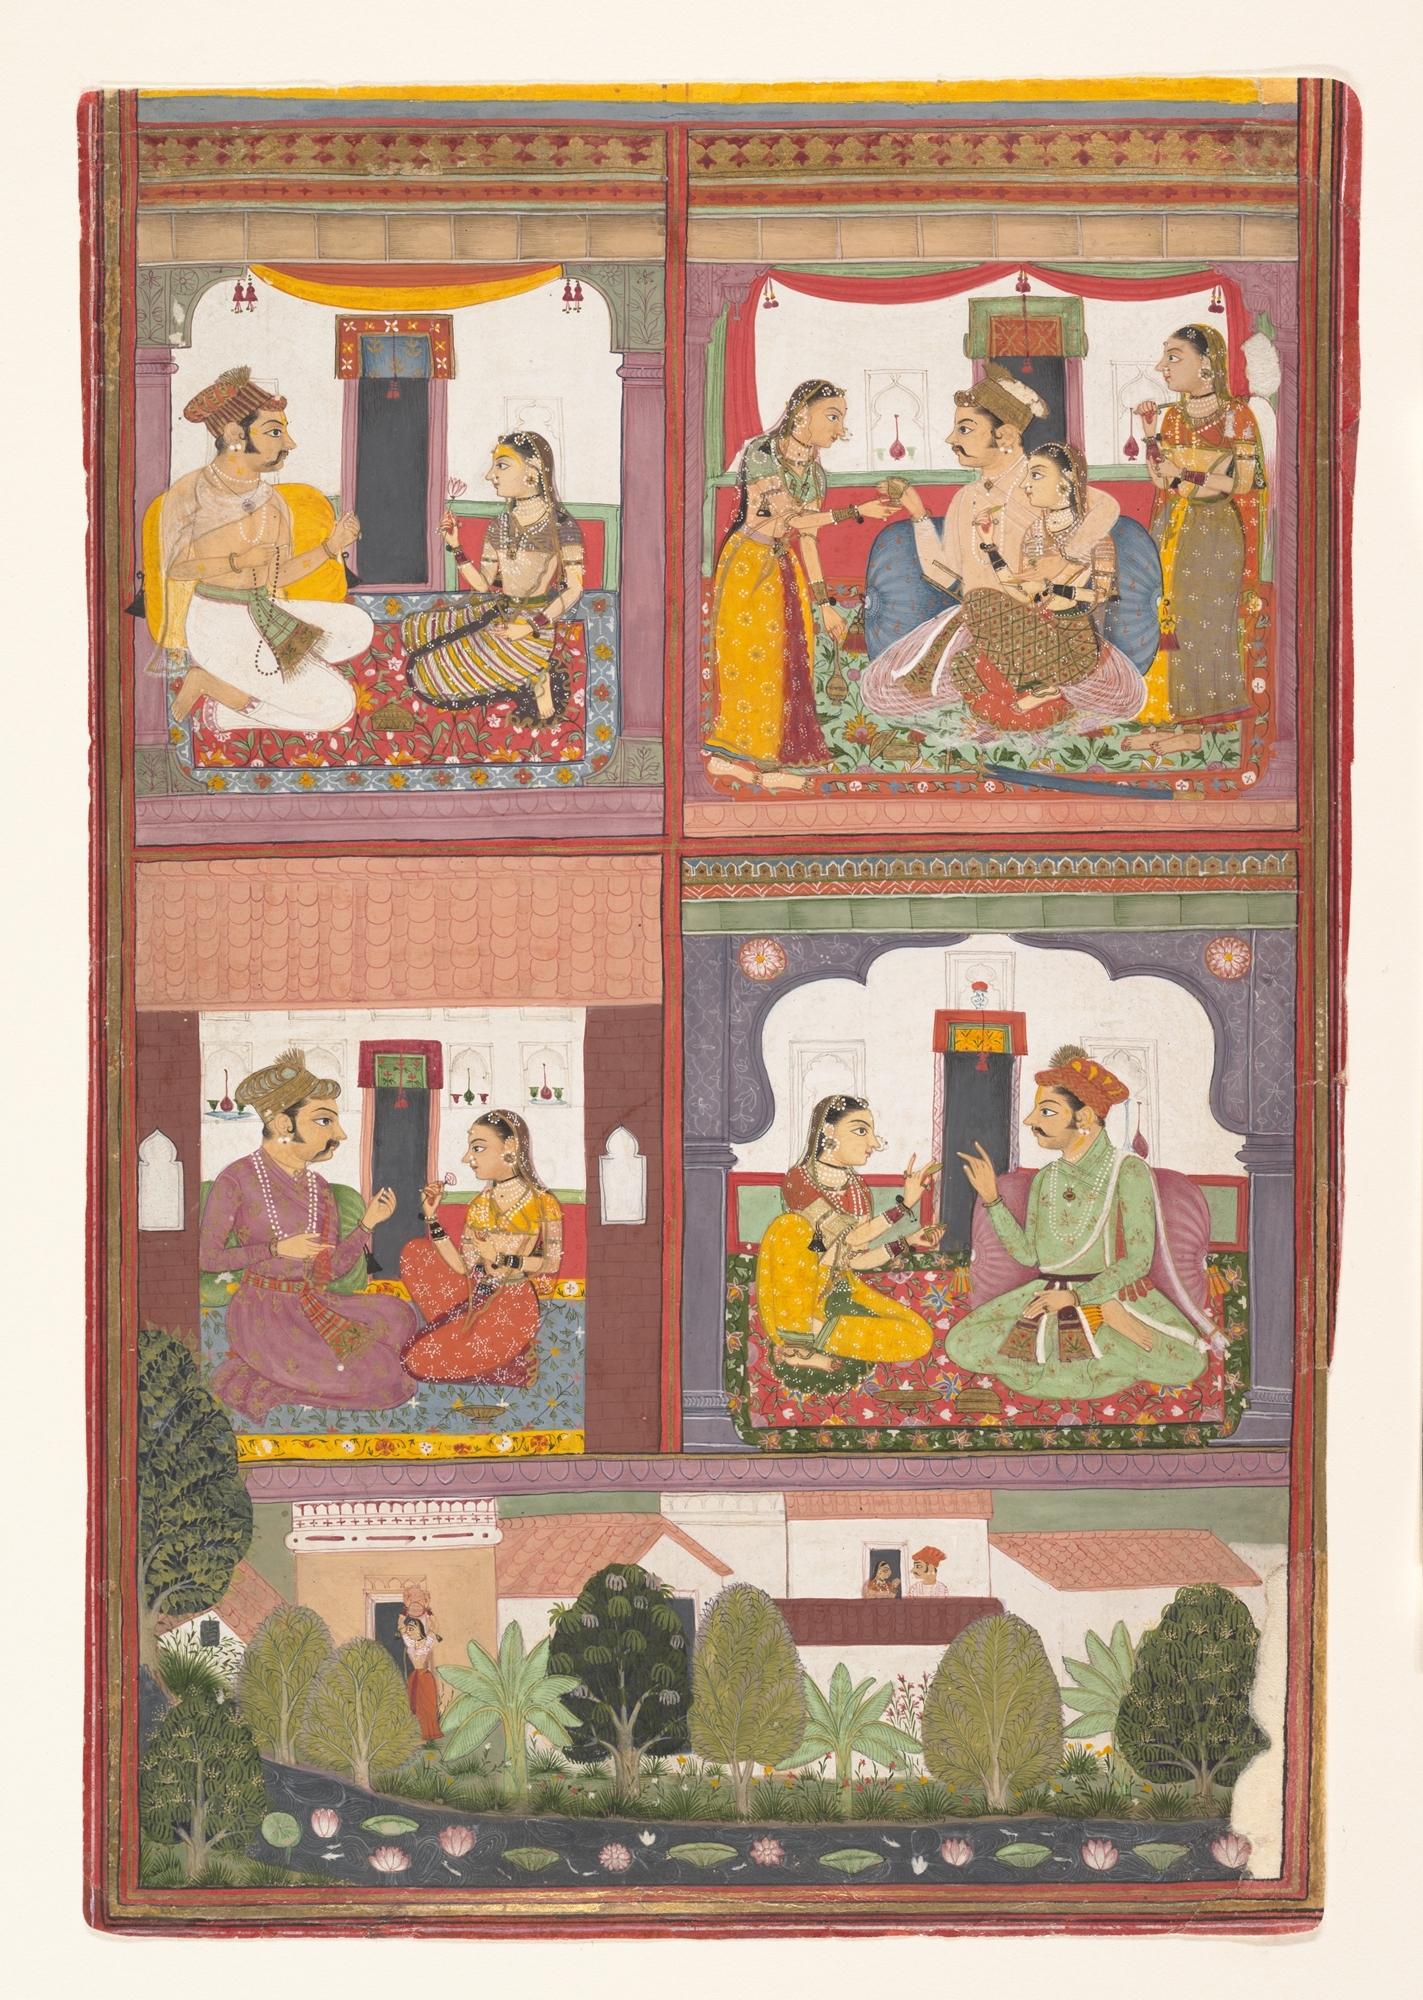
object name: folio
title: Four Love Scenes and a Landscape: Page from a Dispersed Raskapriya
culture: indian or rajasthan or bundi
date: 1700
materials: ink, paper, watercolor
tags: couples,men,women